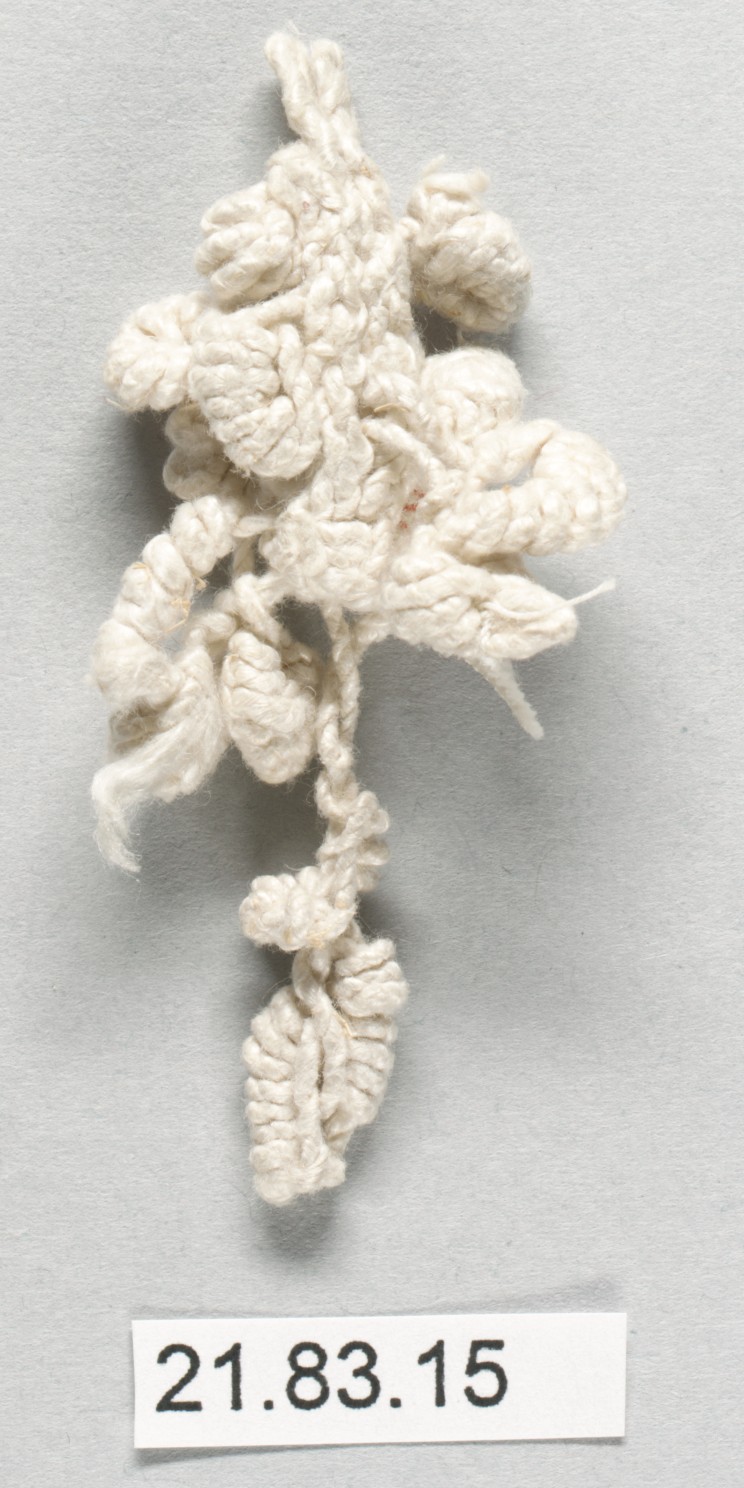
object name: tassel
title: Pair of tassels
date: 1601-1700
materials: linen